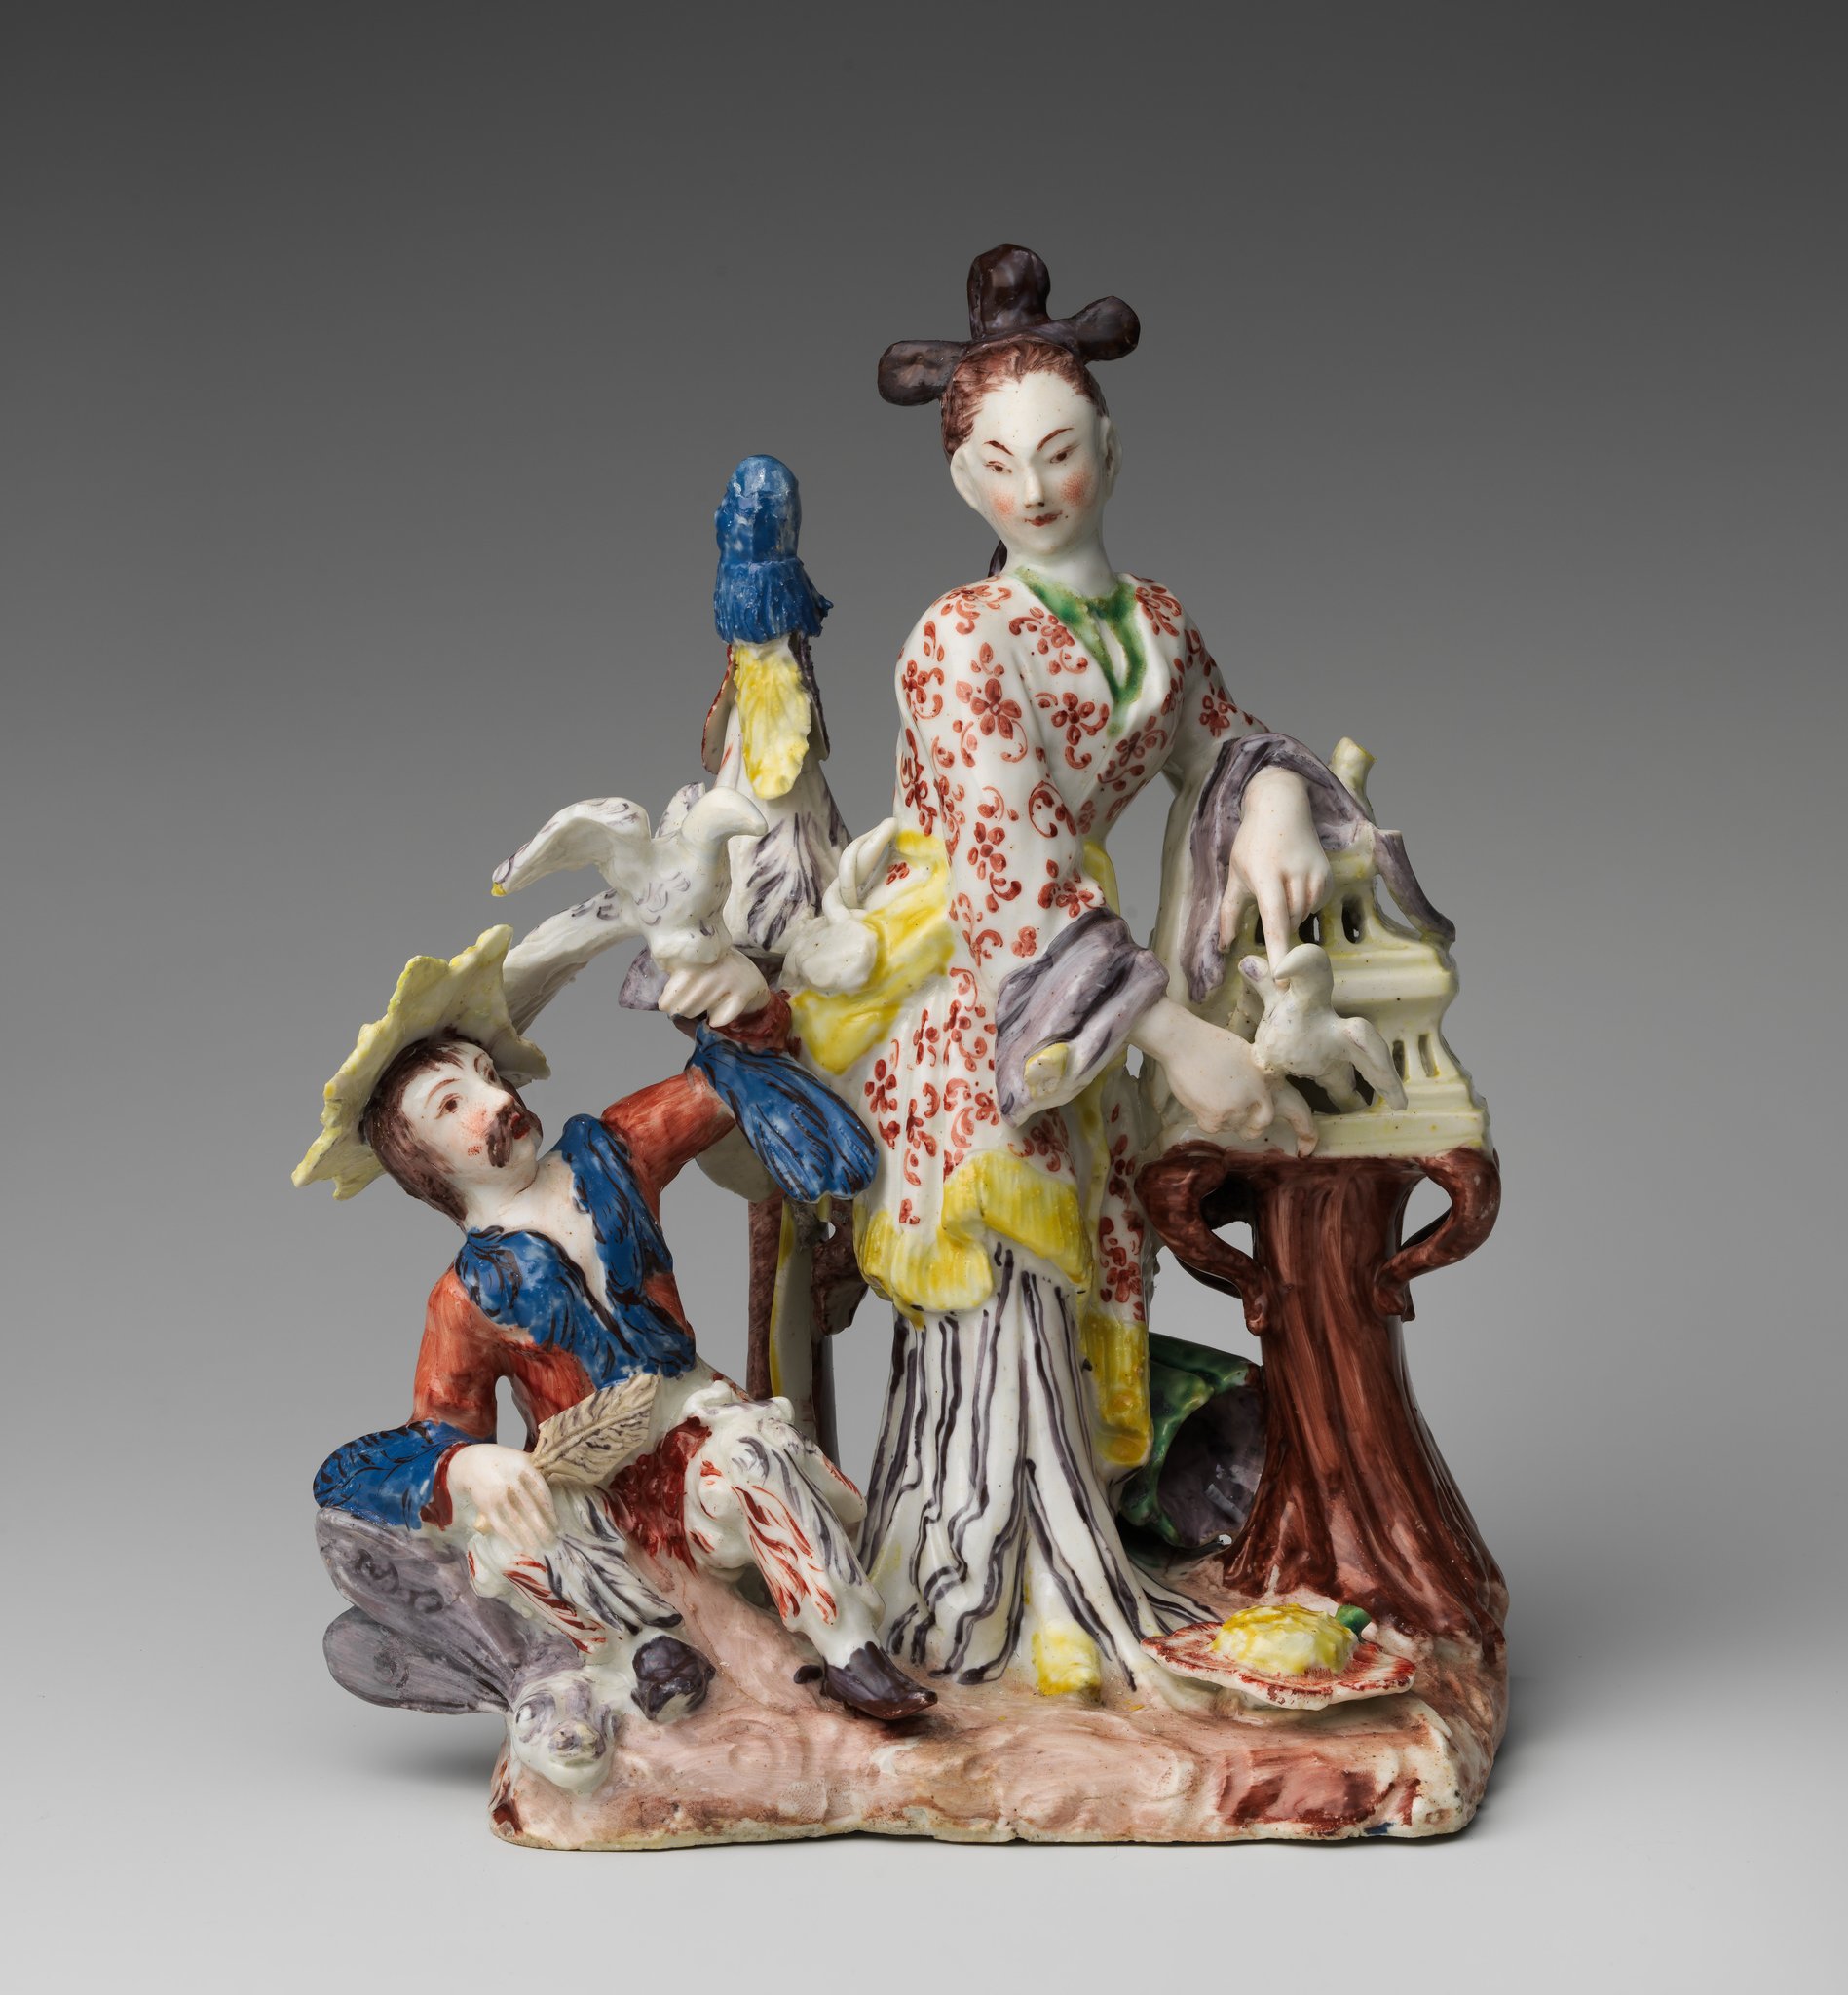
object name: group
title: Air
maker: bow porcelain factory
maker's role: factory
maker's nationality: british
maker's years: 1747-1776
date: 1748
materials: soft paste porcelain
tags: birds,men,women